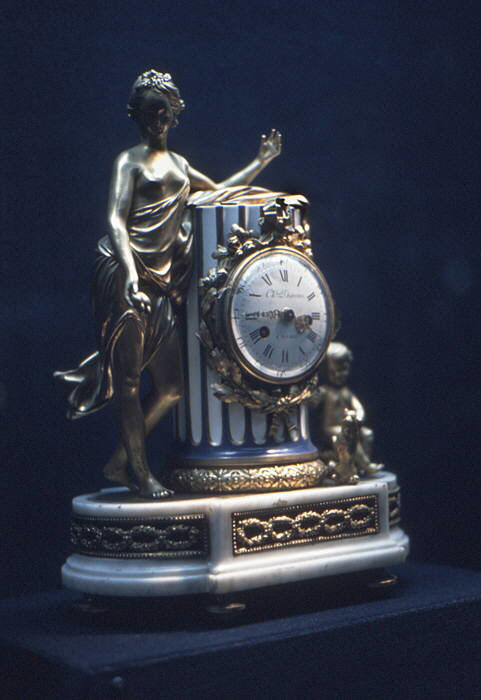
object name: mantel clock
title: Mantel clock (pendule de cheminée)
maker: charles-nicolas dutertre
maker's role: maker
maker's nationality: french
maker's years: 1728-1793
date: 1775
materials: enamel, gilt bronze, marble, porcelain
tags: children,female nudes